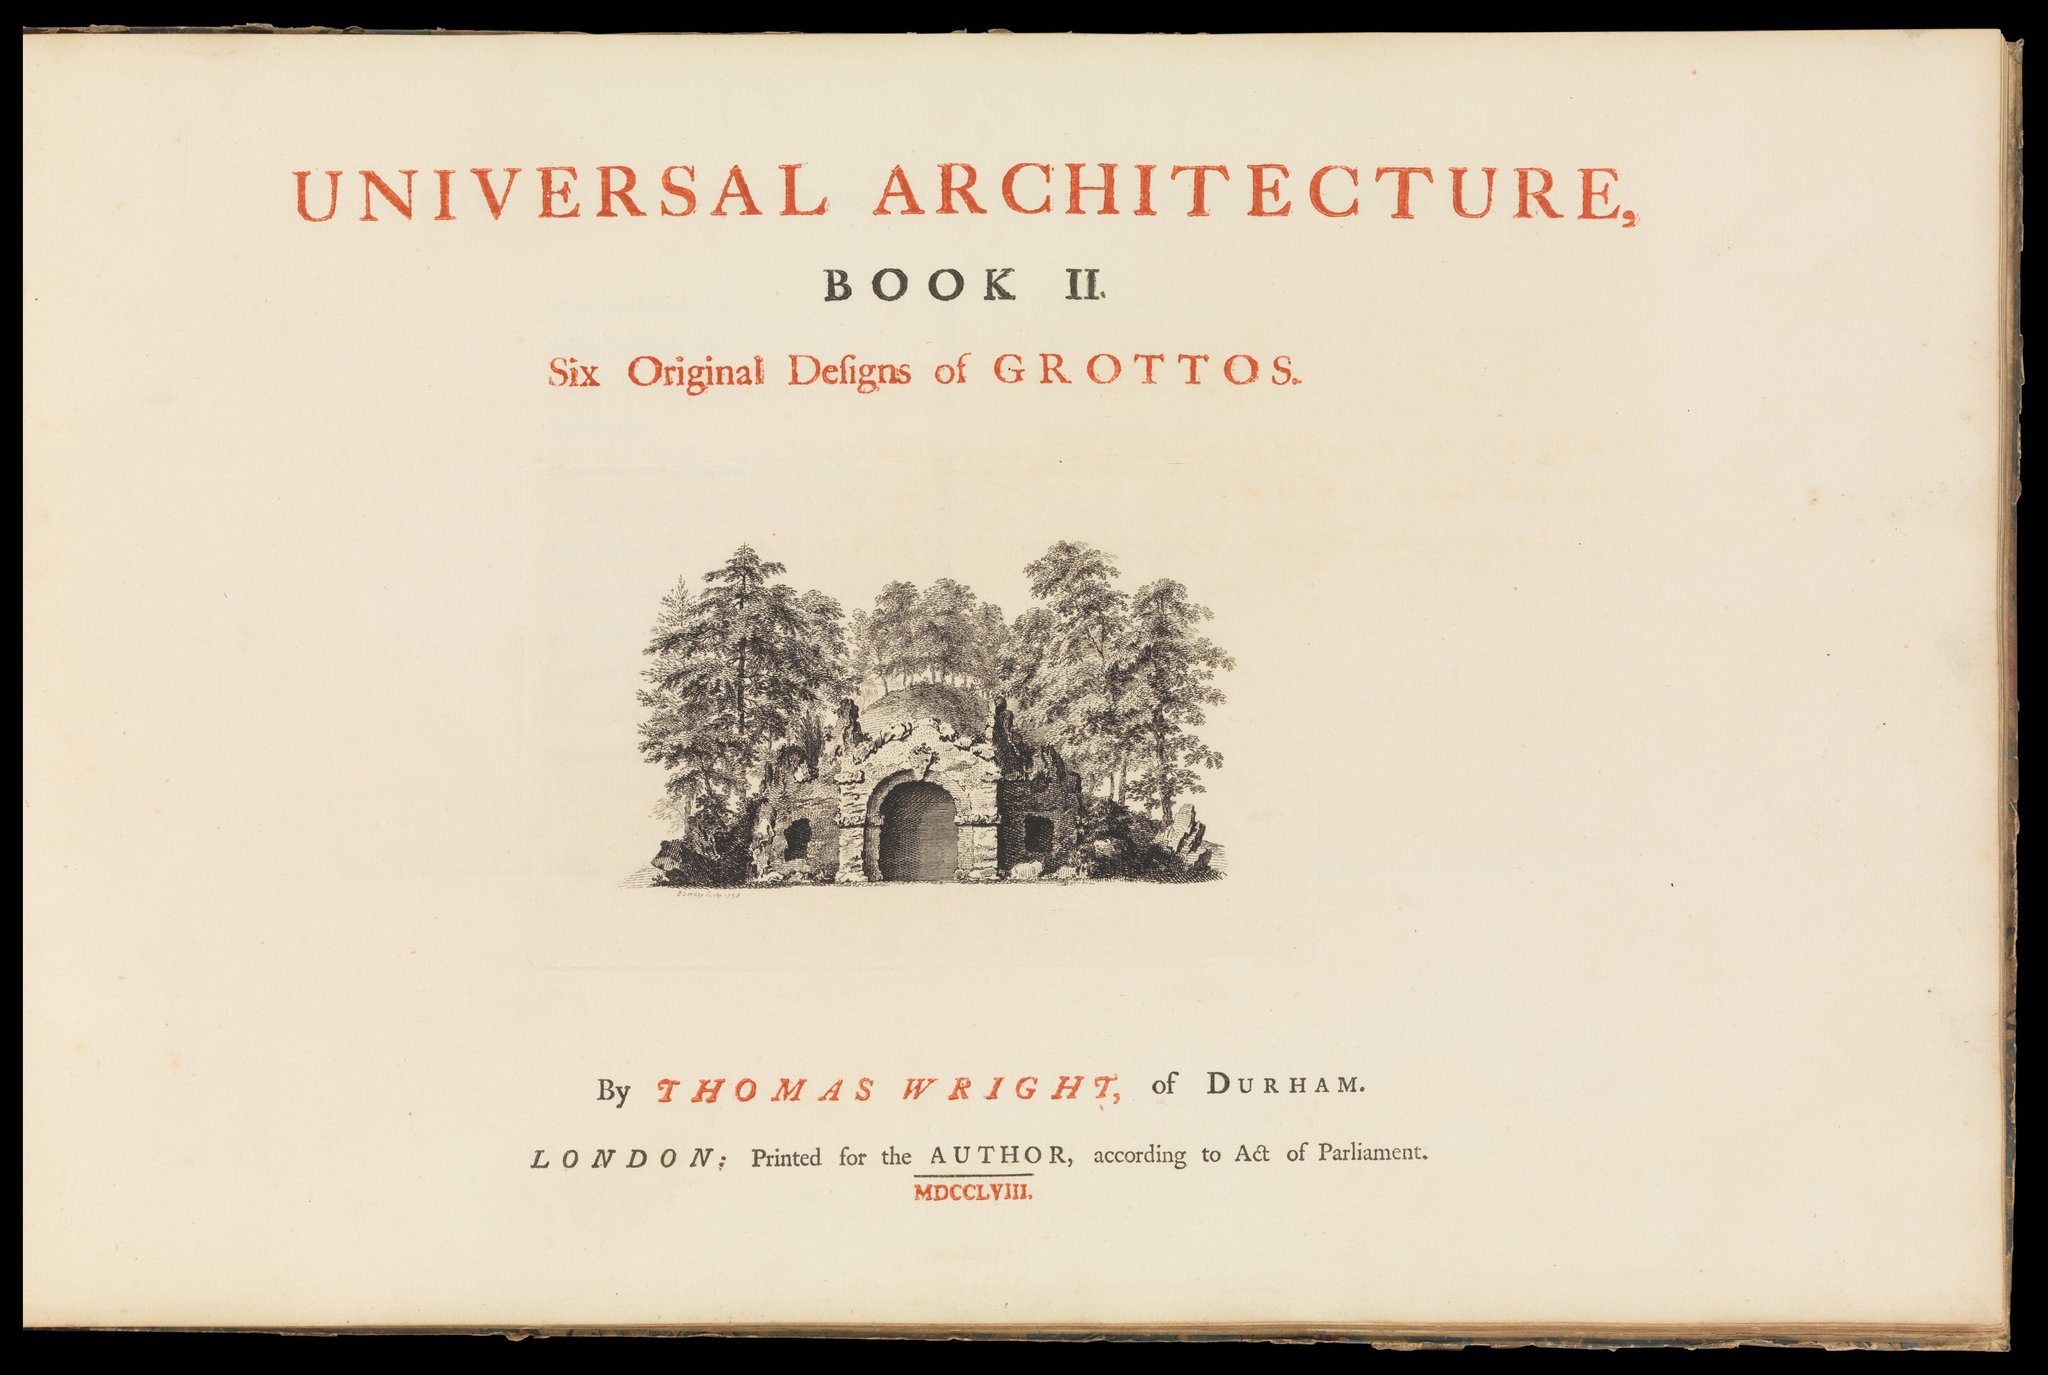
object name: book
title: Universal Architecture: Book I, Six Original Designs of Arbours; Book II, Six Original Designs for Grottoes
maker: thomas wright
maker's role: author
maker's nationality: british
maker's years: 1711-1786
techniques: etching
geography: england